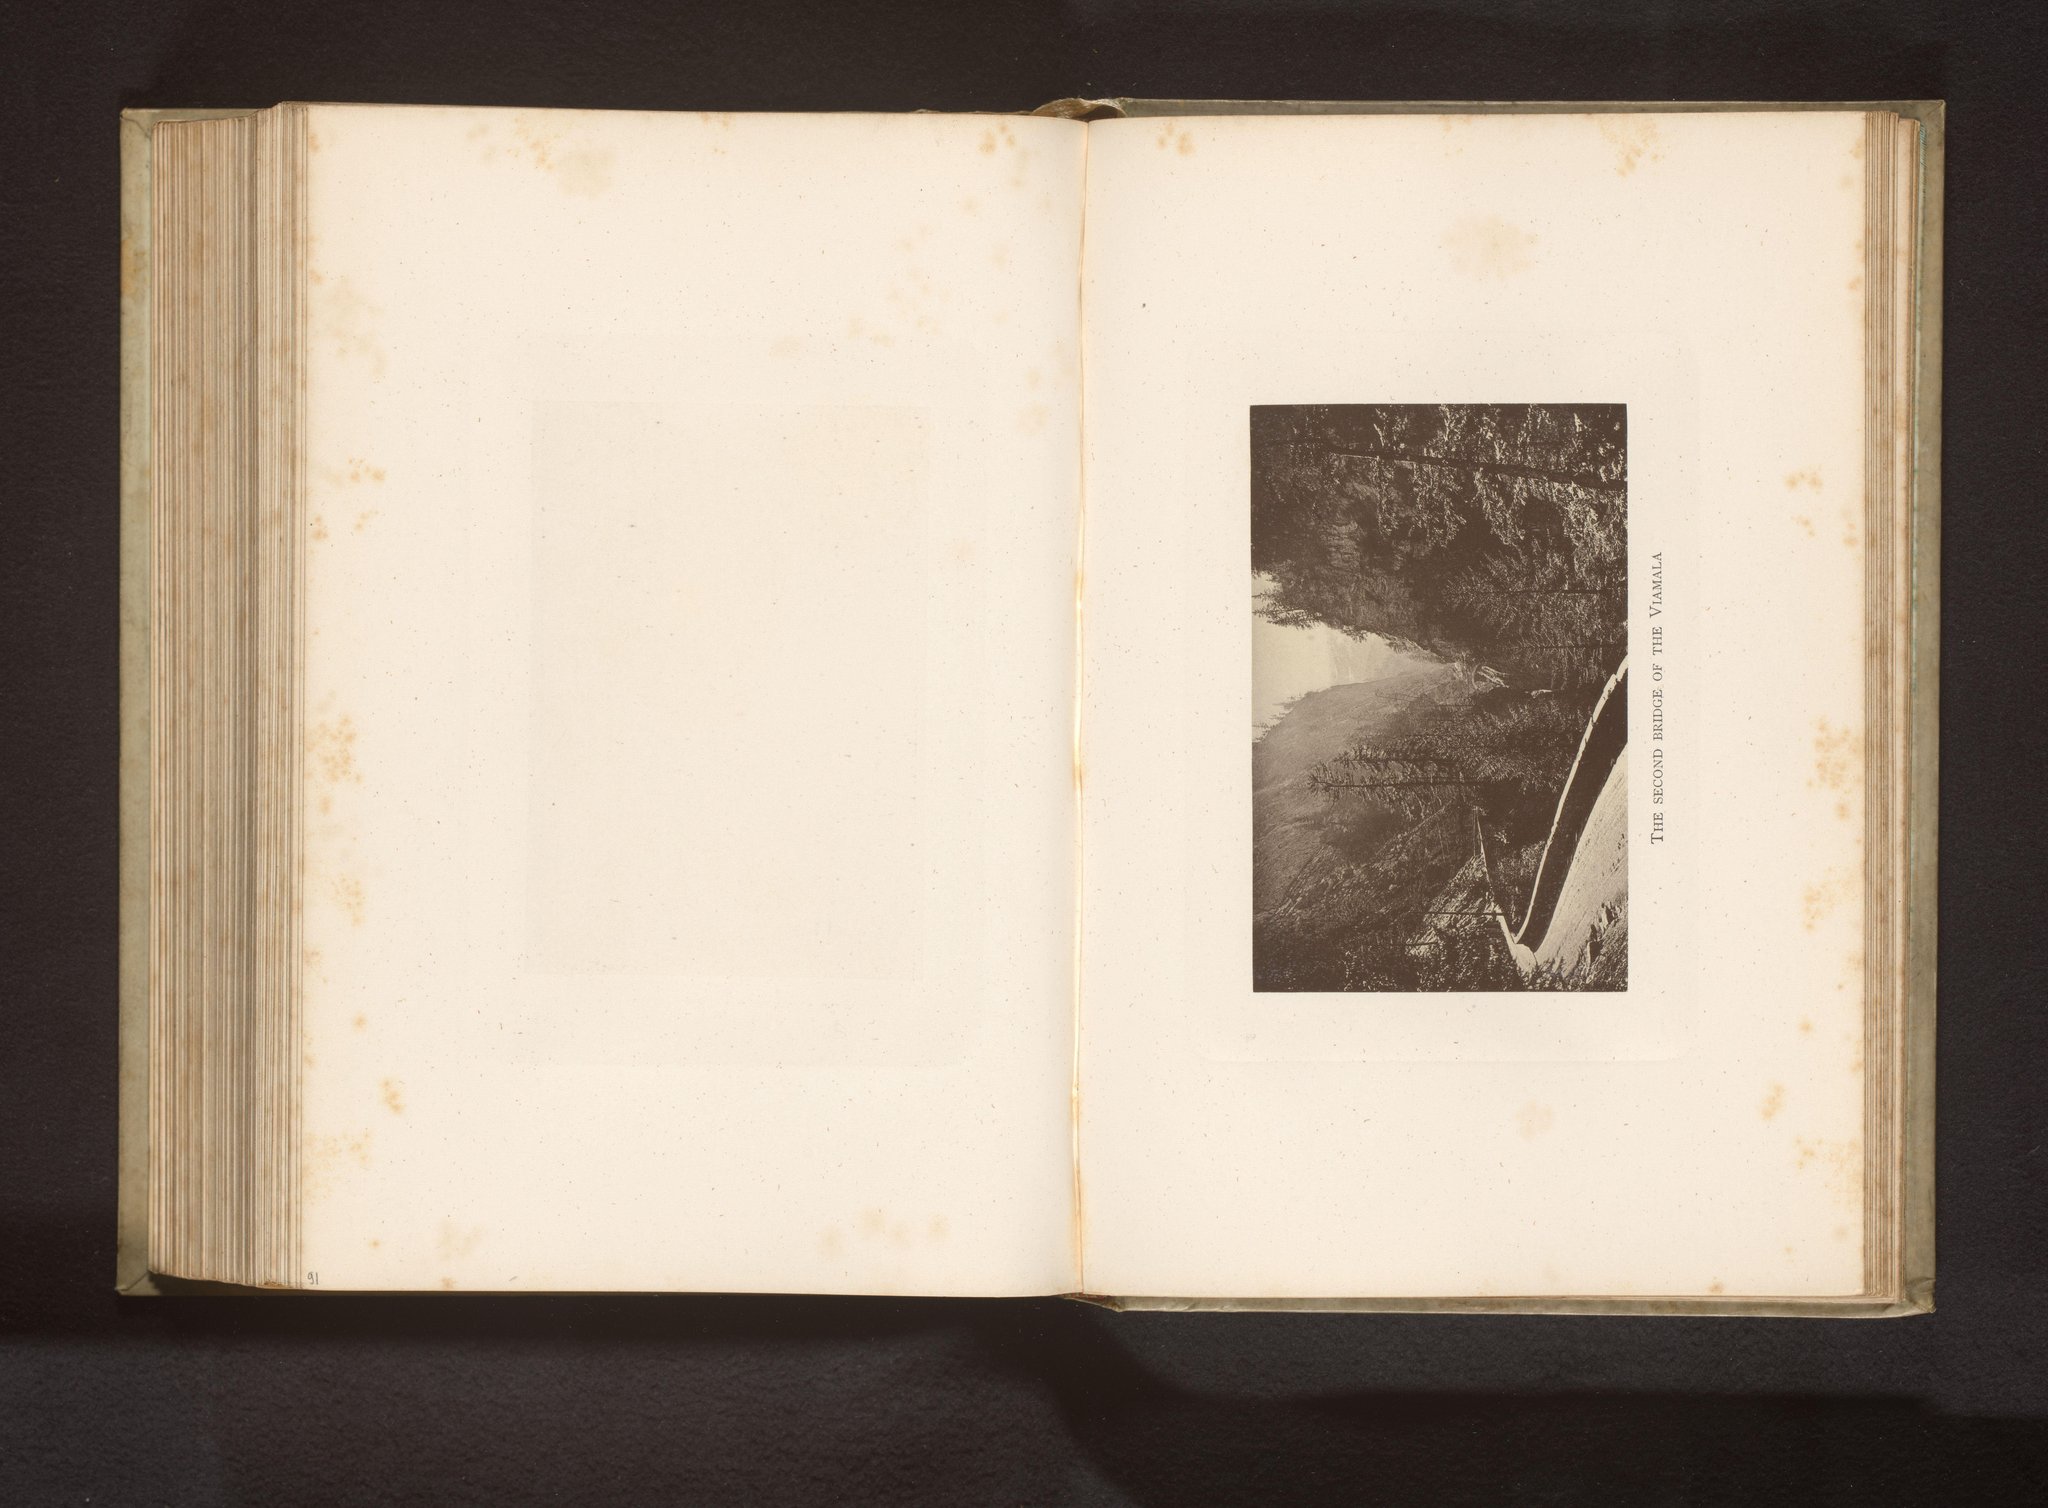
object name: page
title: Gezicht op een brug in de Via Mala in Zwitserland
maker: Anonymous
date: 1874-1884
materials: paper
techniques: photograph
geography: graubunden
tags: road, path, bridge, mountains